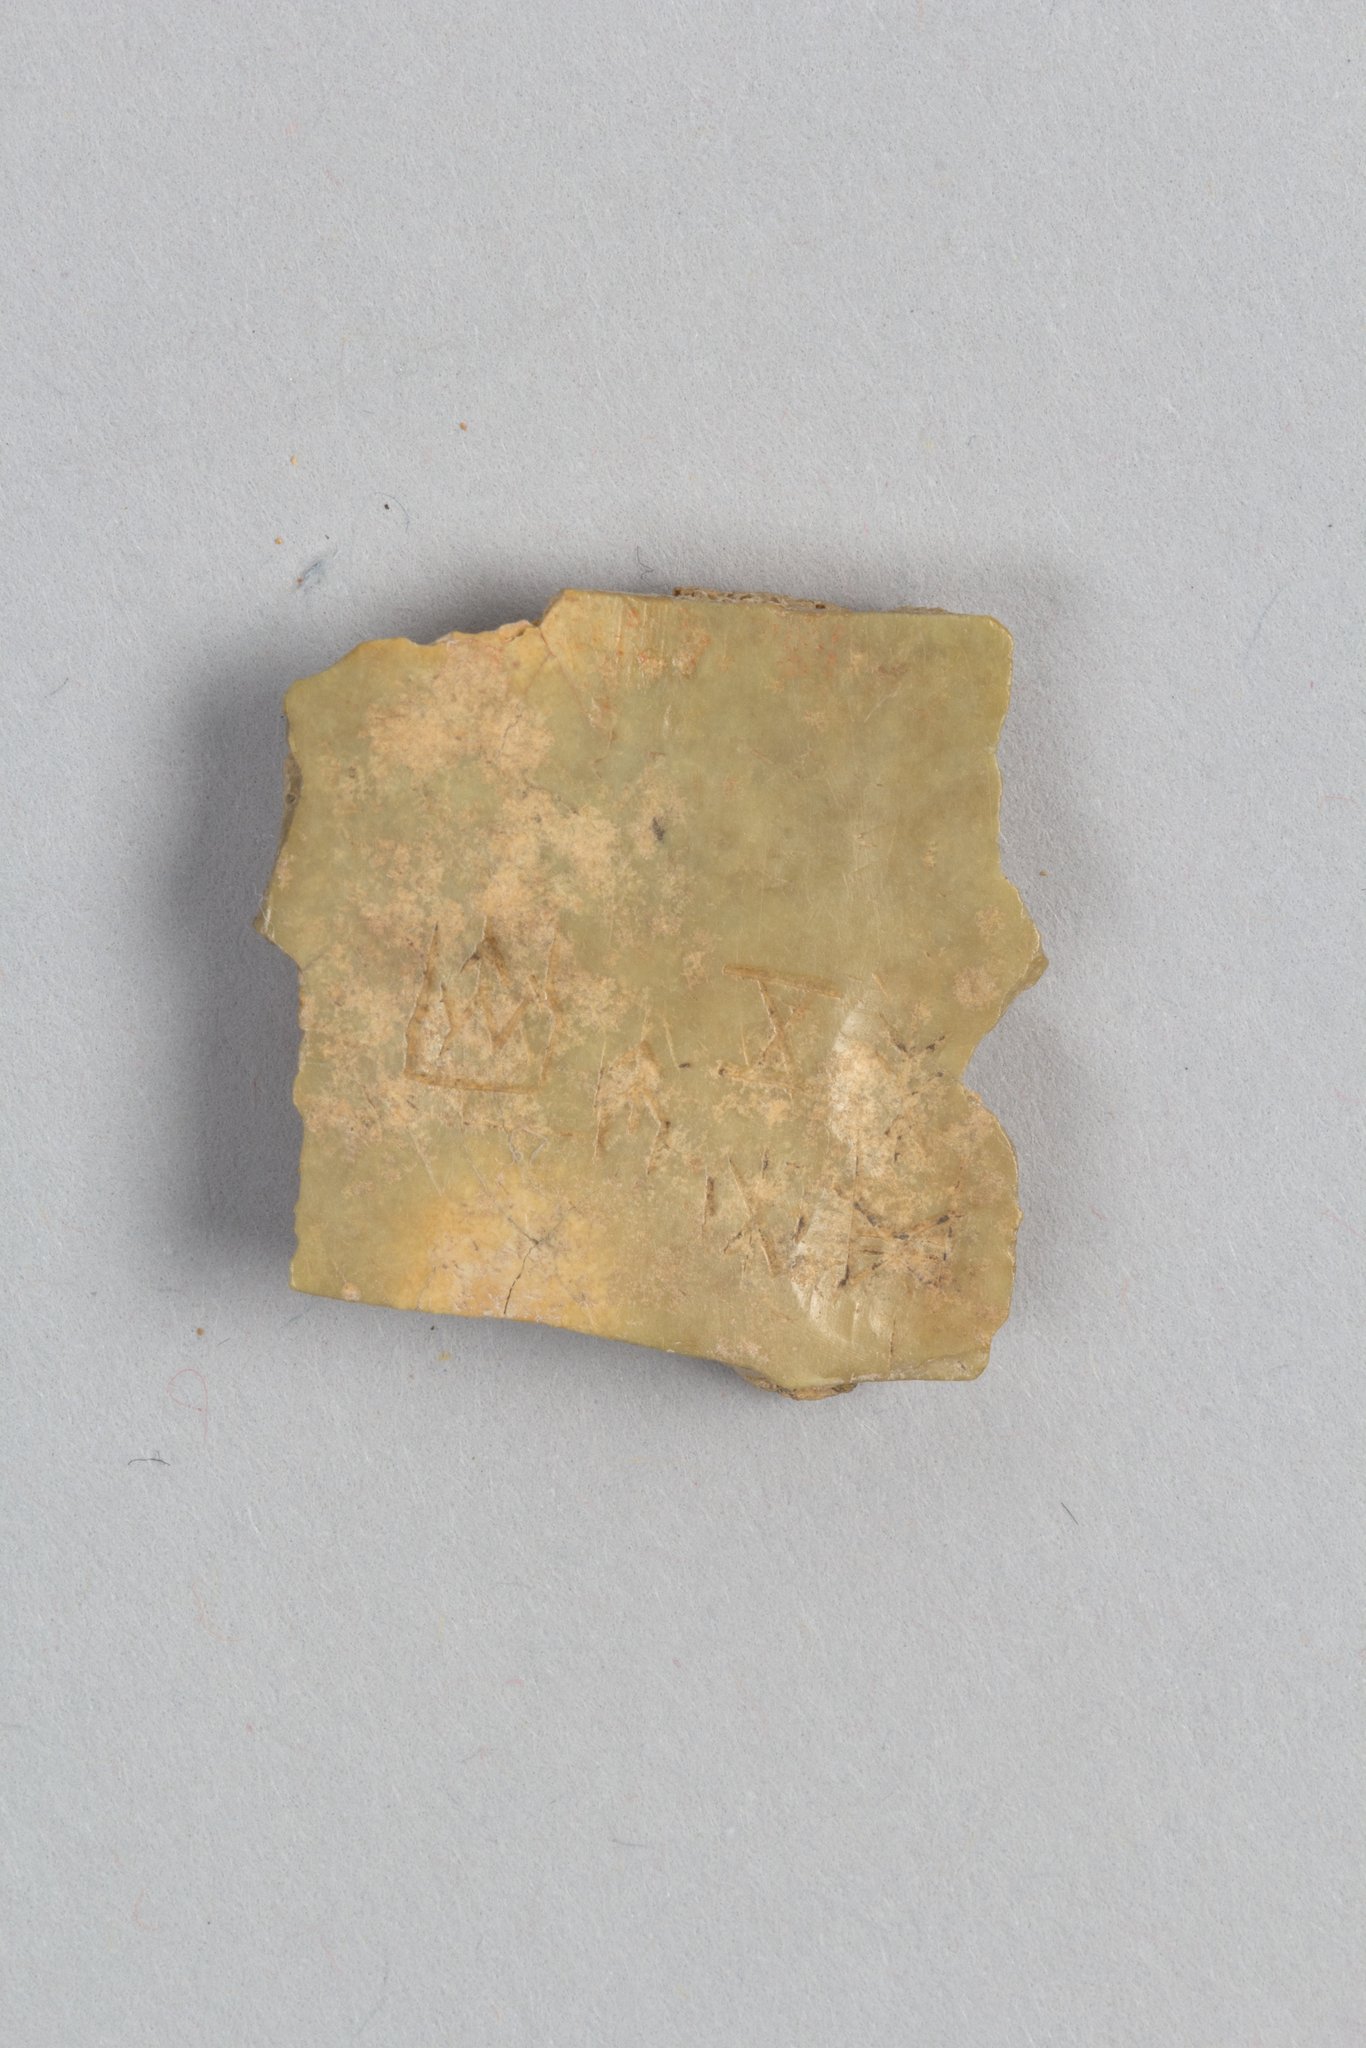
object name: oracle bone fragment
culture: chinese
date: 1600-1046 BCE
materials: bone